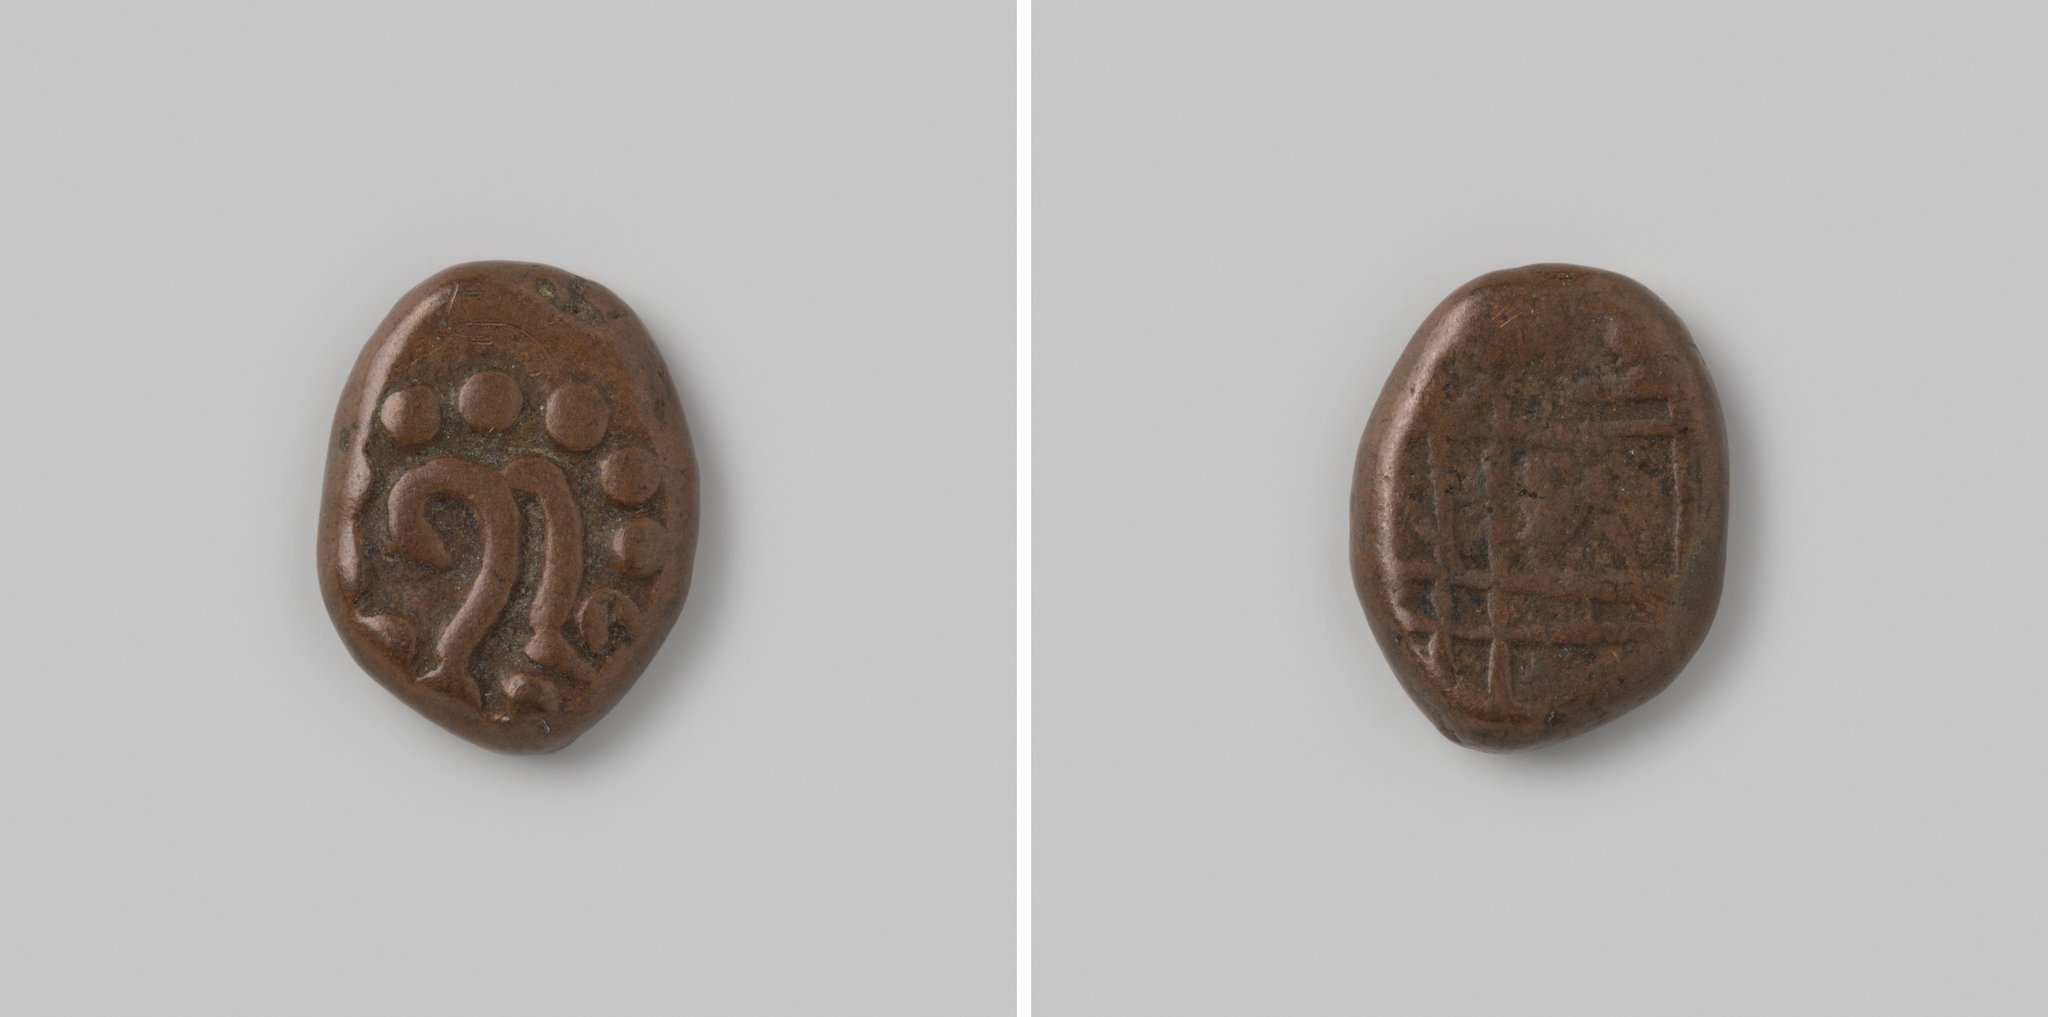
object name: coin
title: Mysore [?], India, cash,1700-1800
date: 1700-1800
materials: copper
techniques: striking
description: Koperen munt. Voorzijde: in Kanarese cijfers aanduiding: 22. Keerzijde: loodrecht op elkaar staande rechte lijnen.